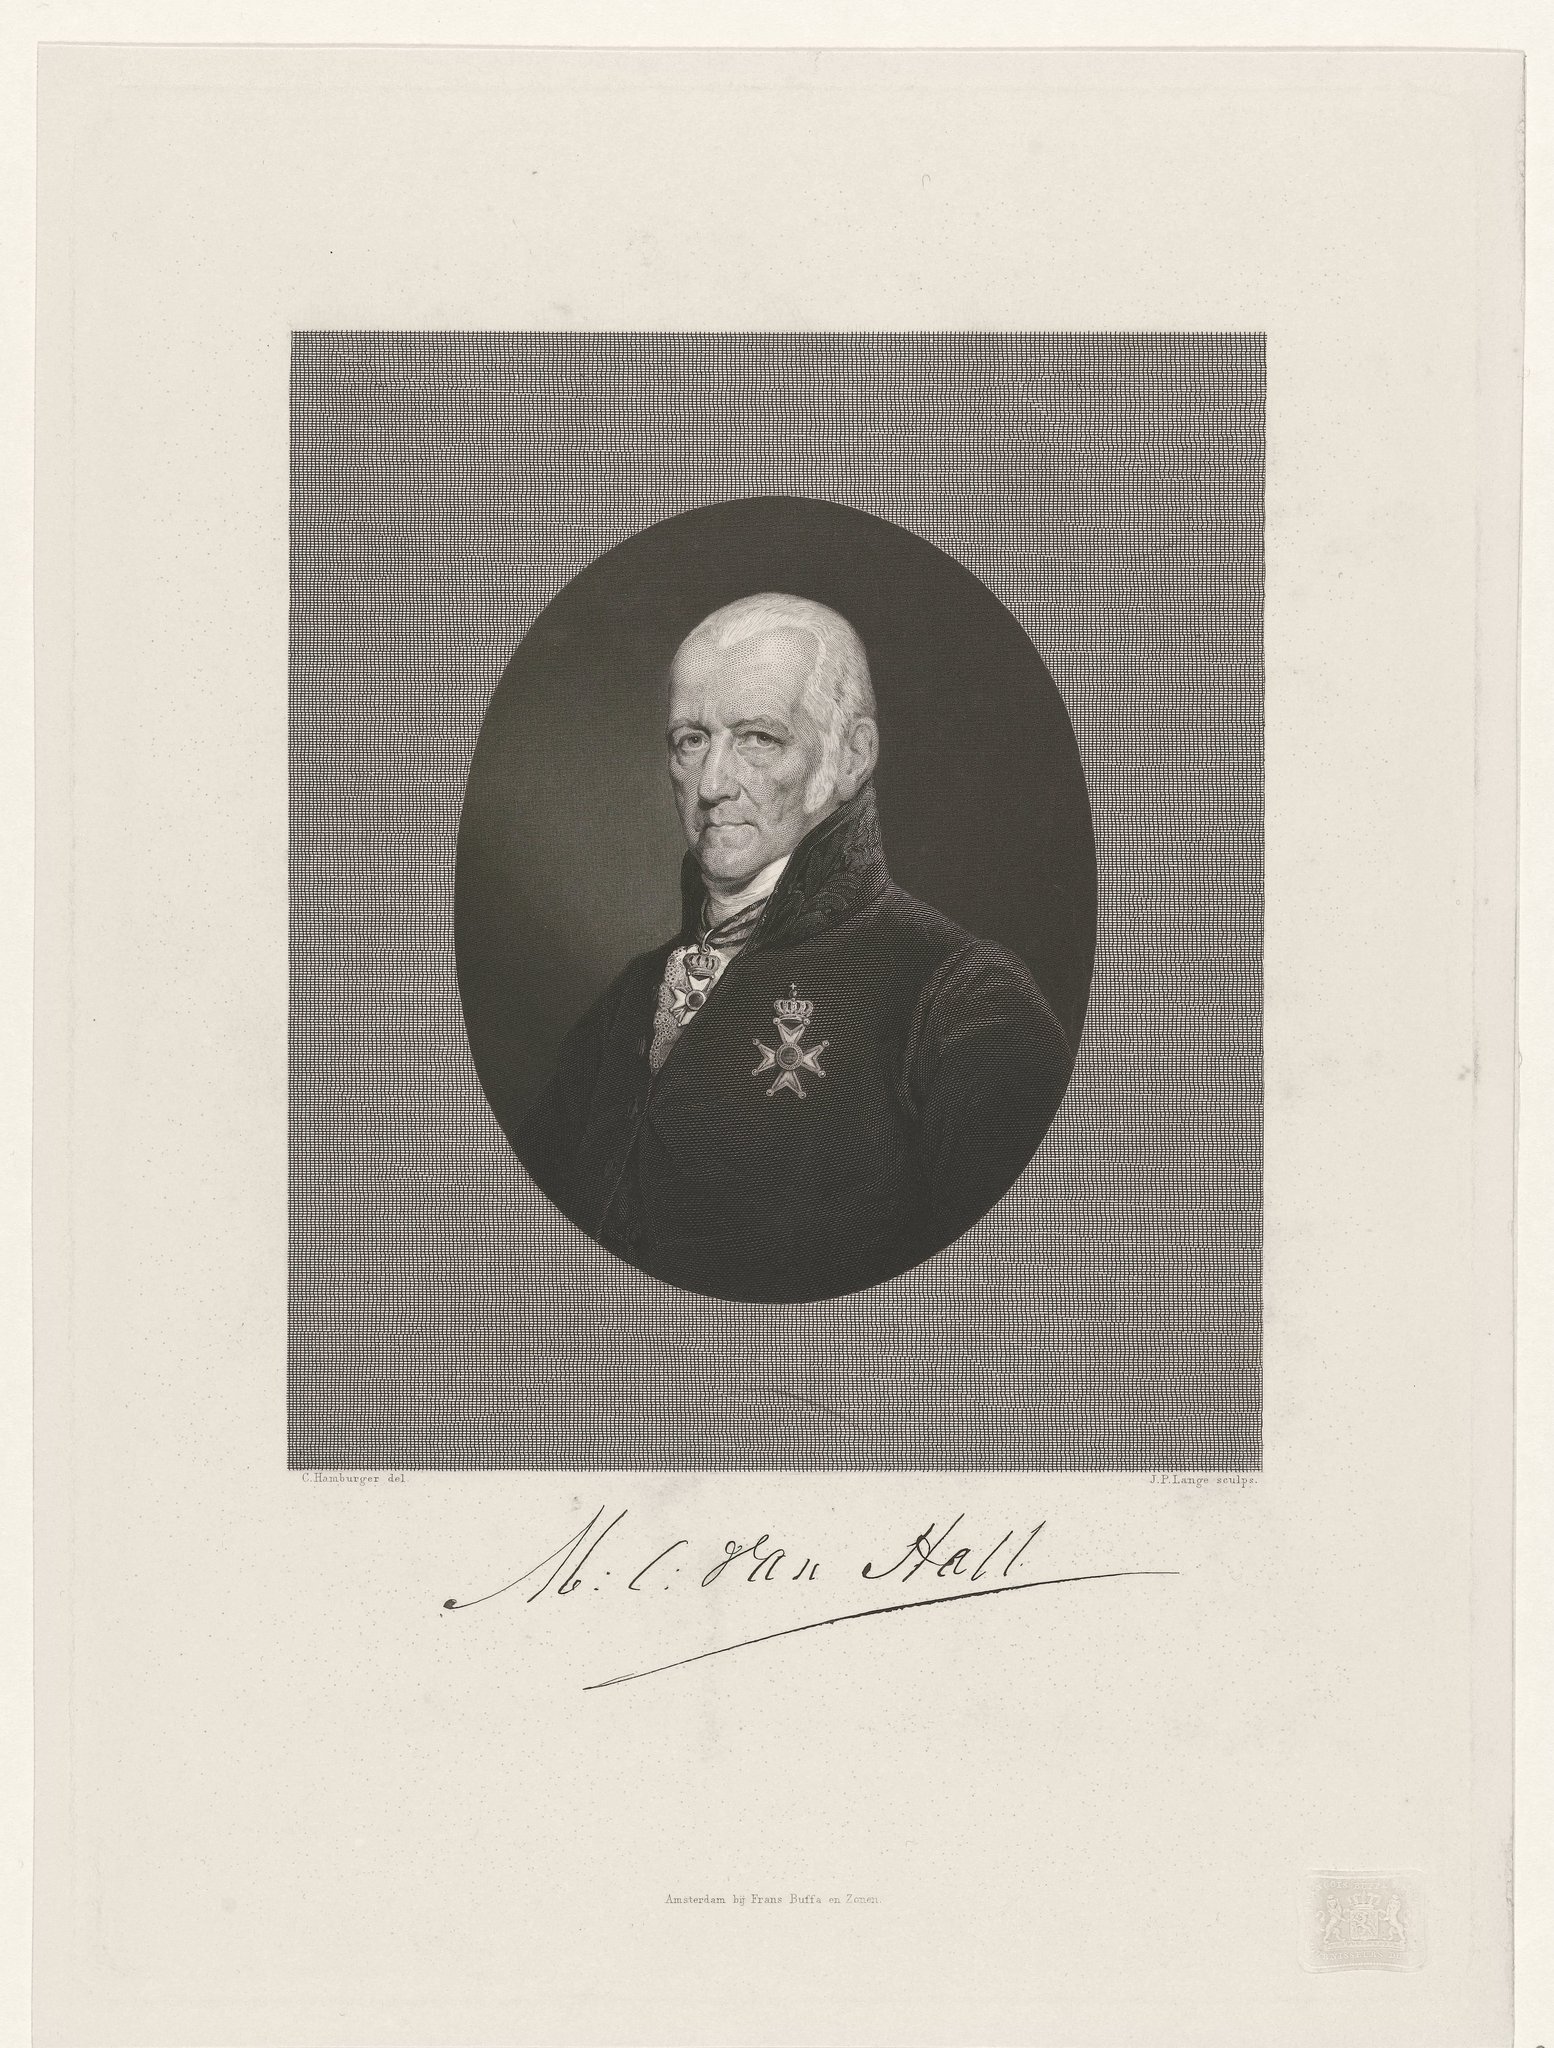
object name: print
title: Portret van Maurits Cornelis van Hall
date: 1848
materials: paper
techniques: engraving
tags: maurits cornelis van hall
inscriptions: check stamp, collector's mark: Lugt 12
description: Portretbuste in ovaal naar links van Maurits Cornelis van Hall, rechtsgeleerde, blootshoofds en gehuld in galakleding.